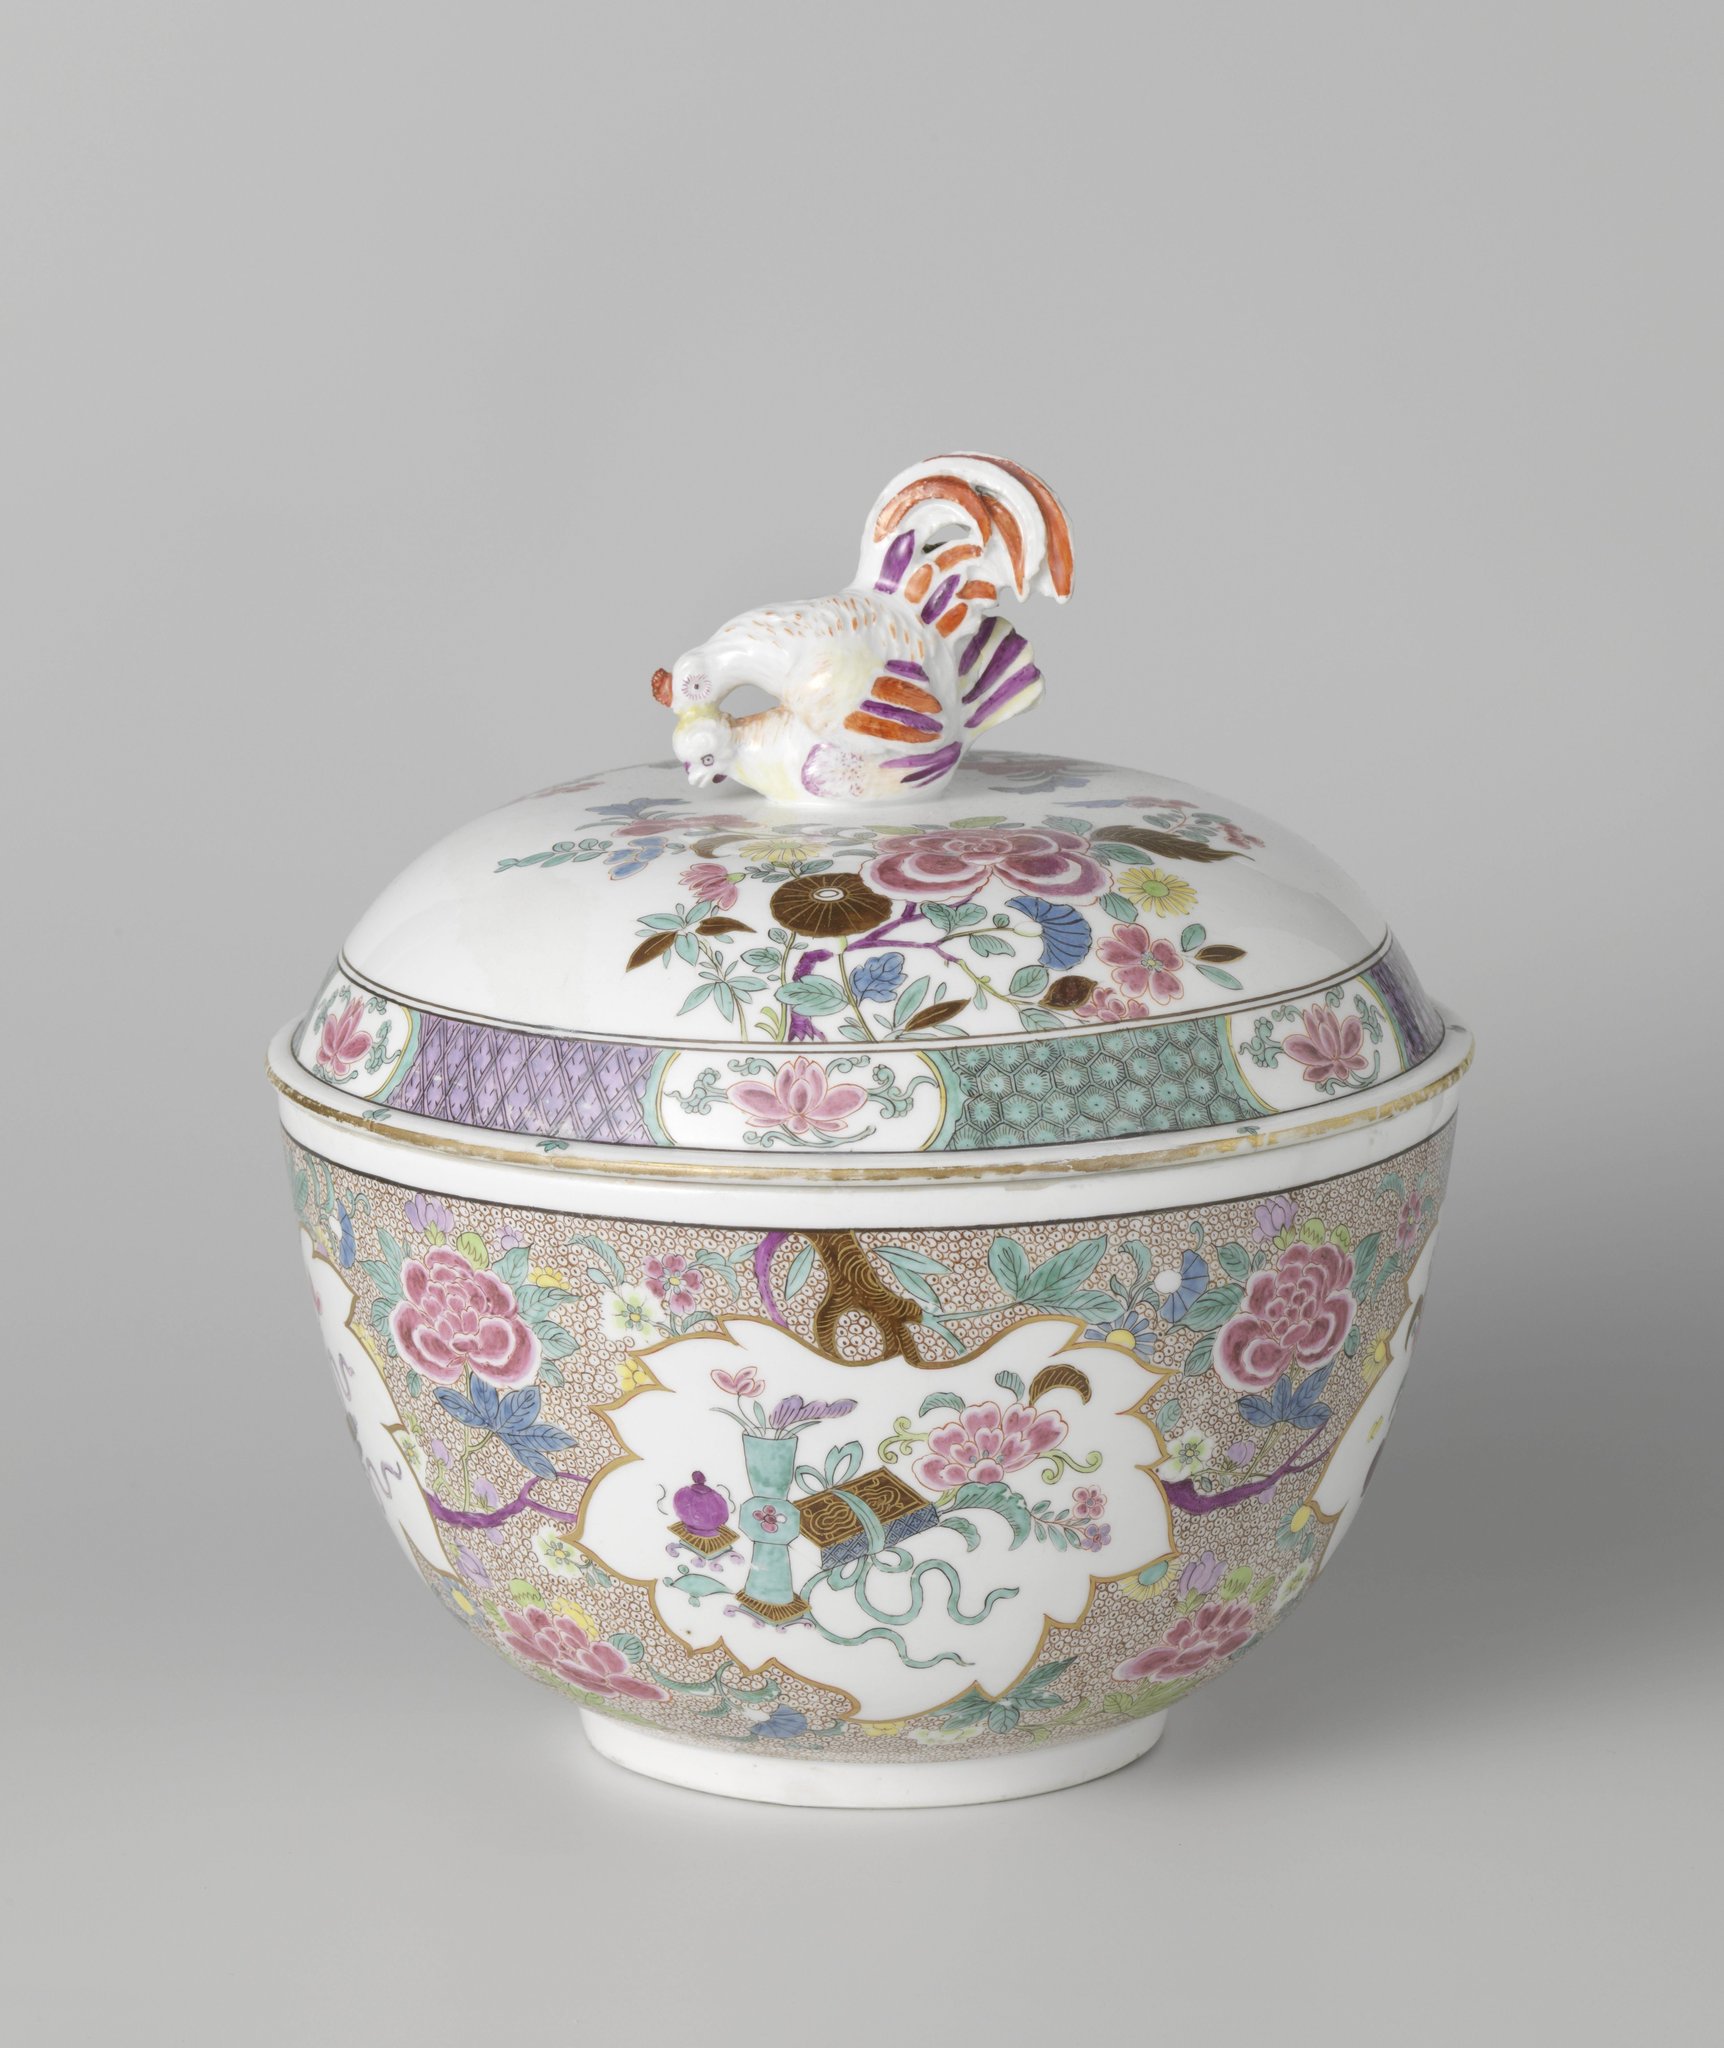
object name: lid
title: Deksel van terrine, beschilderd in famille rose-stijl naar Chinees voorbeeld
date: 1735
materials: porcelain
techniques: painted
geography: meissen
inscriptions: mold mark, factory mark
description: Deksel van terrine, van veelkleurig beschilderd porselein. De knop van het deksel heeft de vorm van een parende kip en haan.